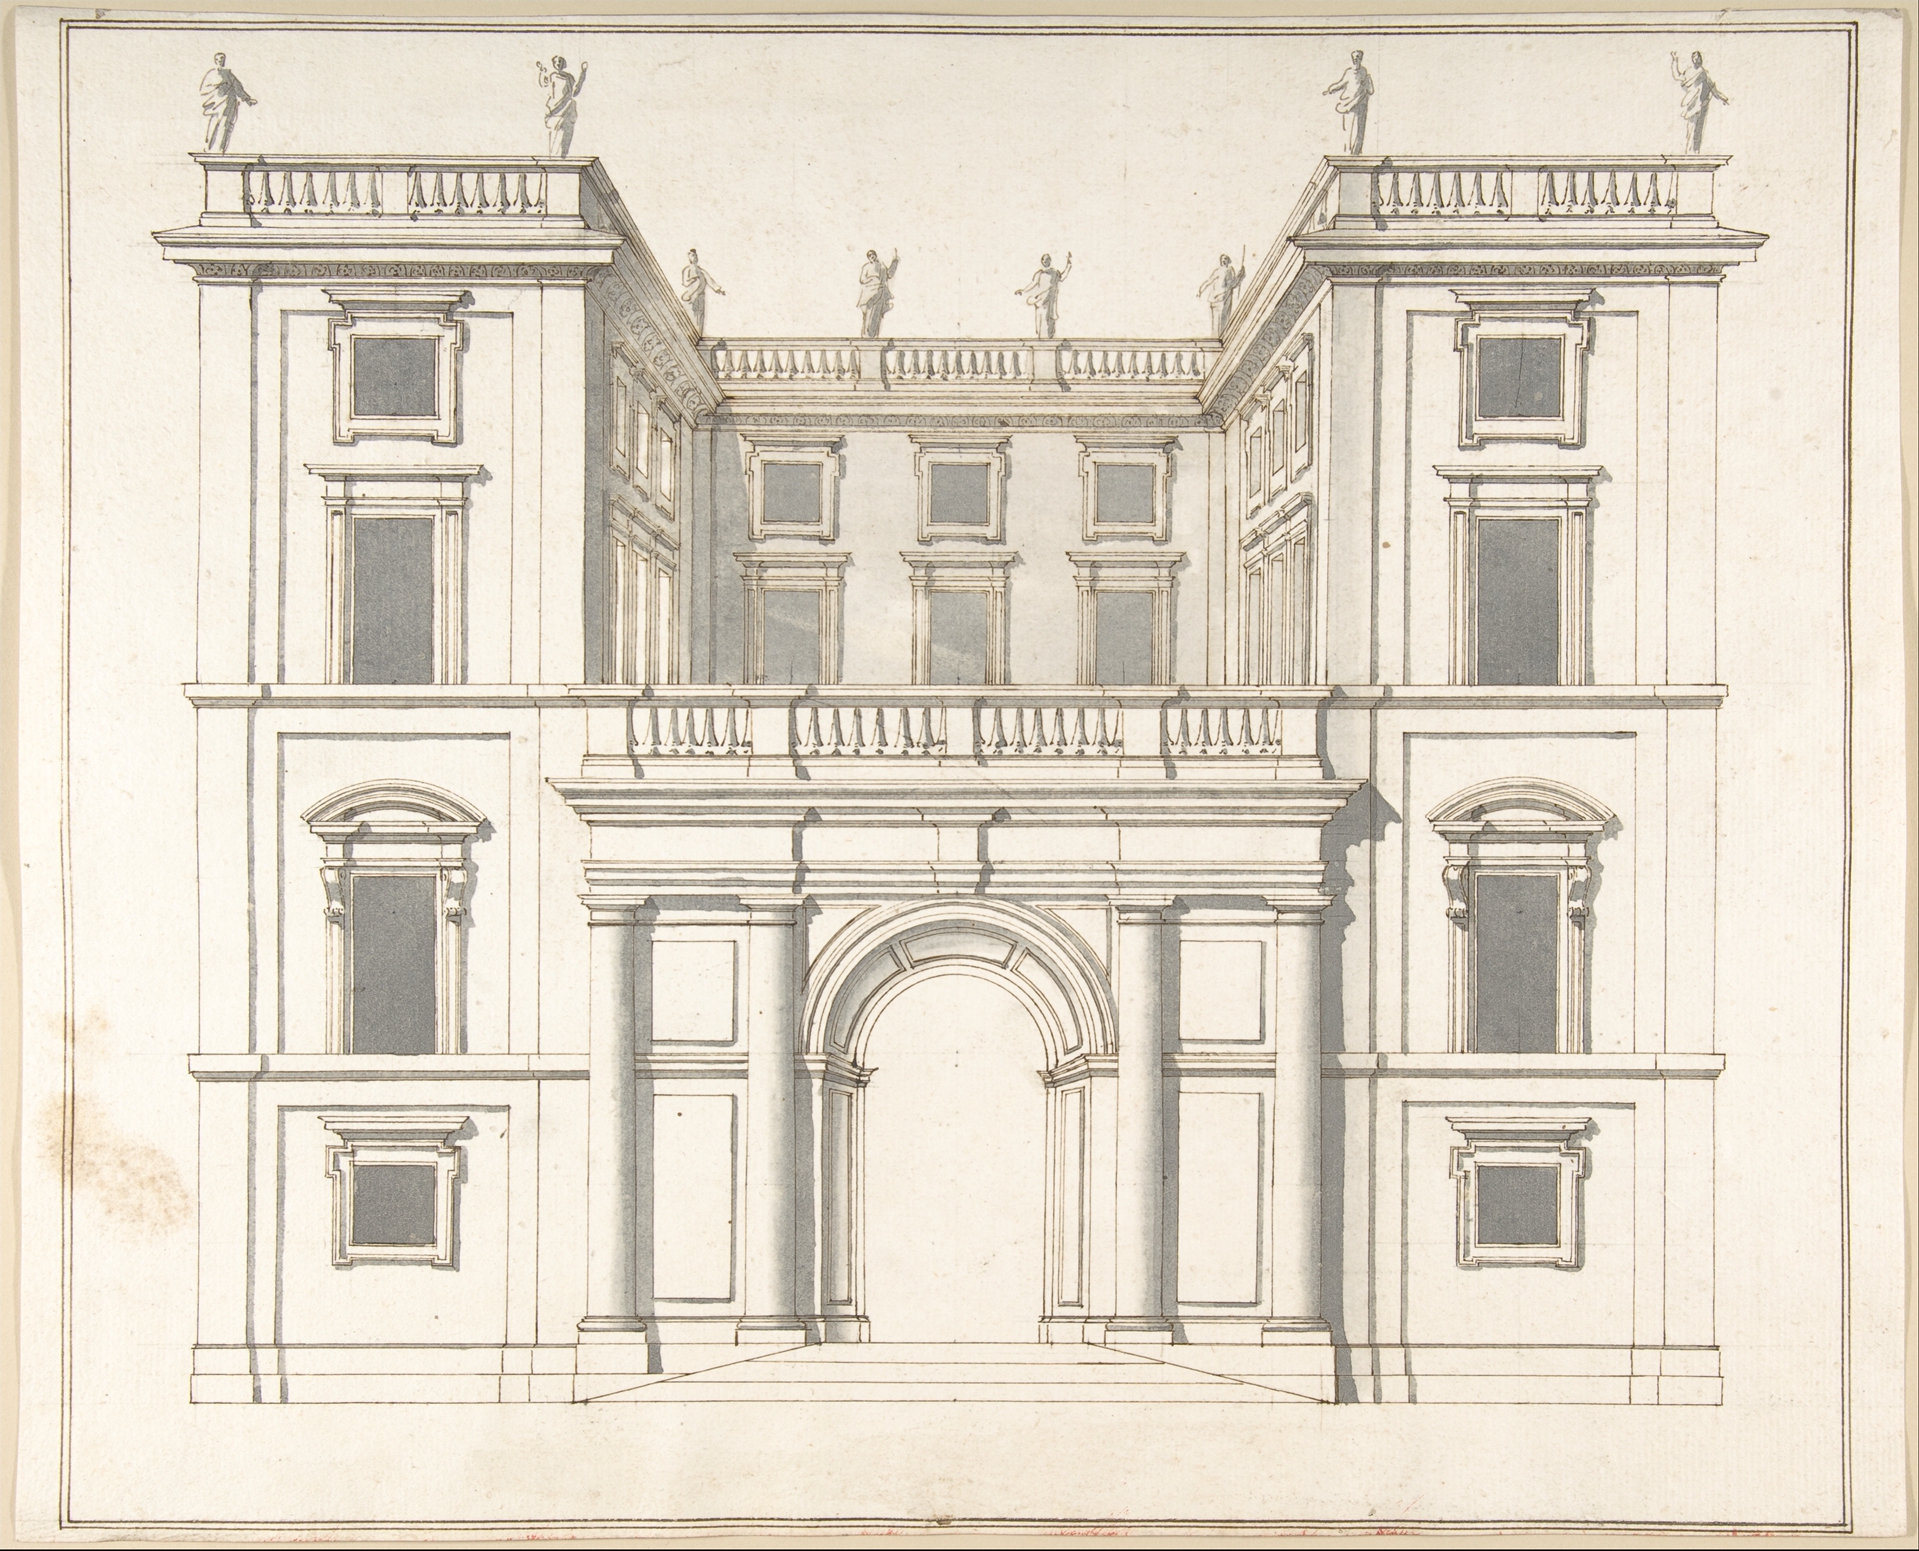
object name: drawing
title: Façade of Palazzo Muti at Piazza SS. Apostoli in Rome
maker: pietro paolo coccetti (cocchetti)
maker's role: artist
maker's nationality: italian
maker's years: 1710-1727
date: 1710-1727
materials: graphite, ink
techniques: brush, pen, wash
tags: architecture,buildings